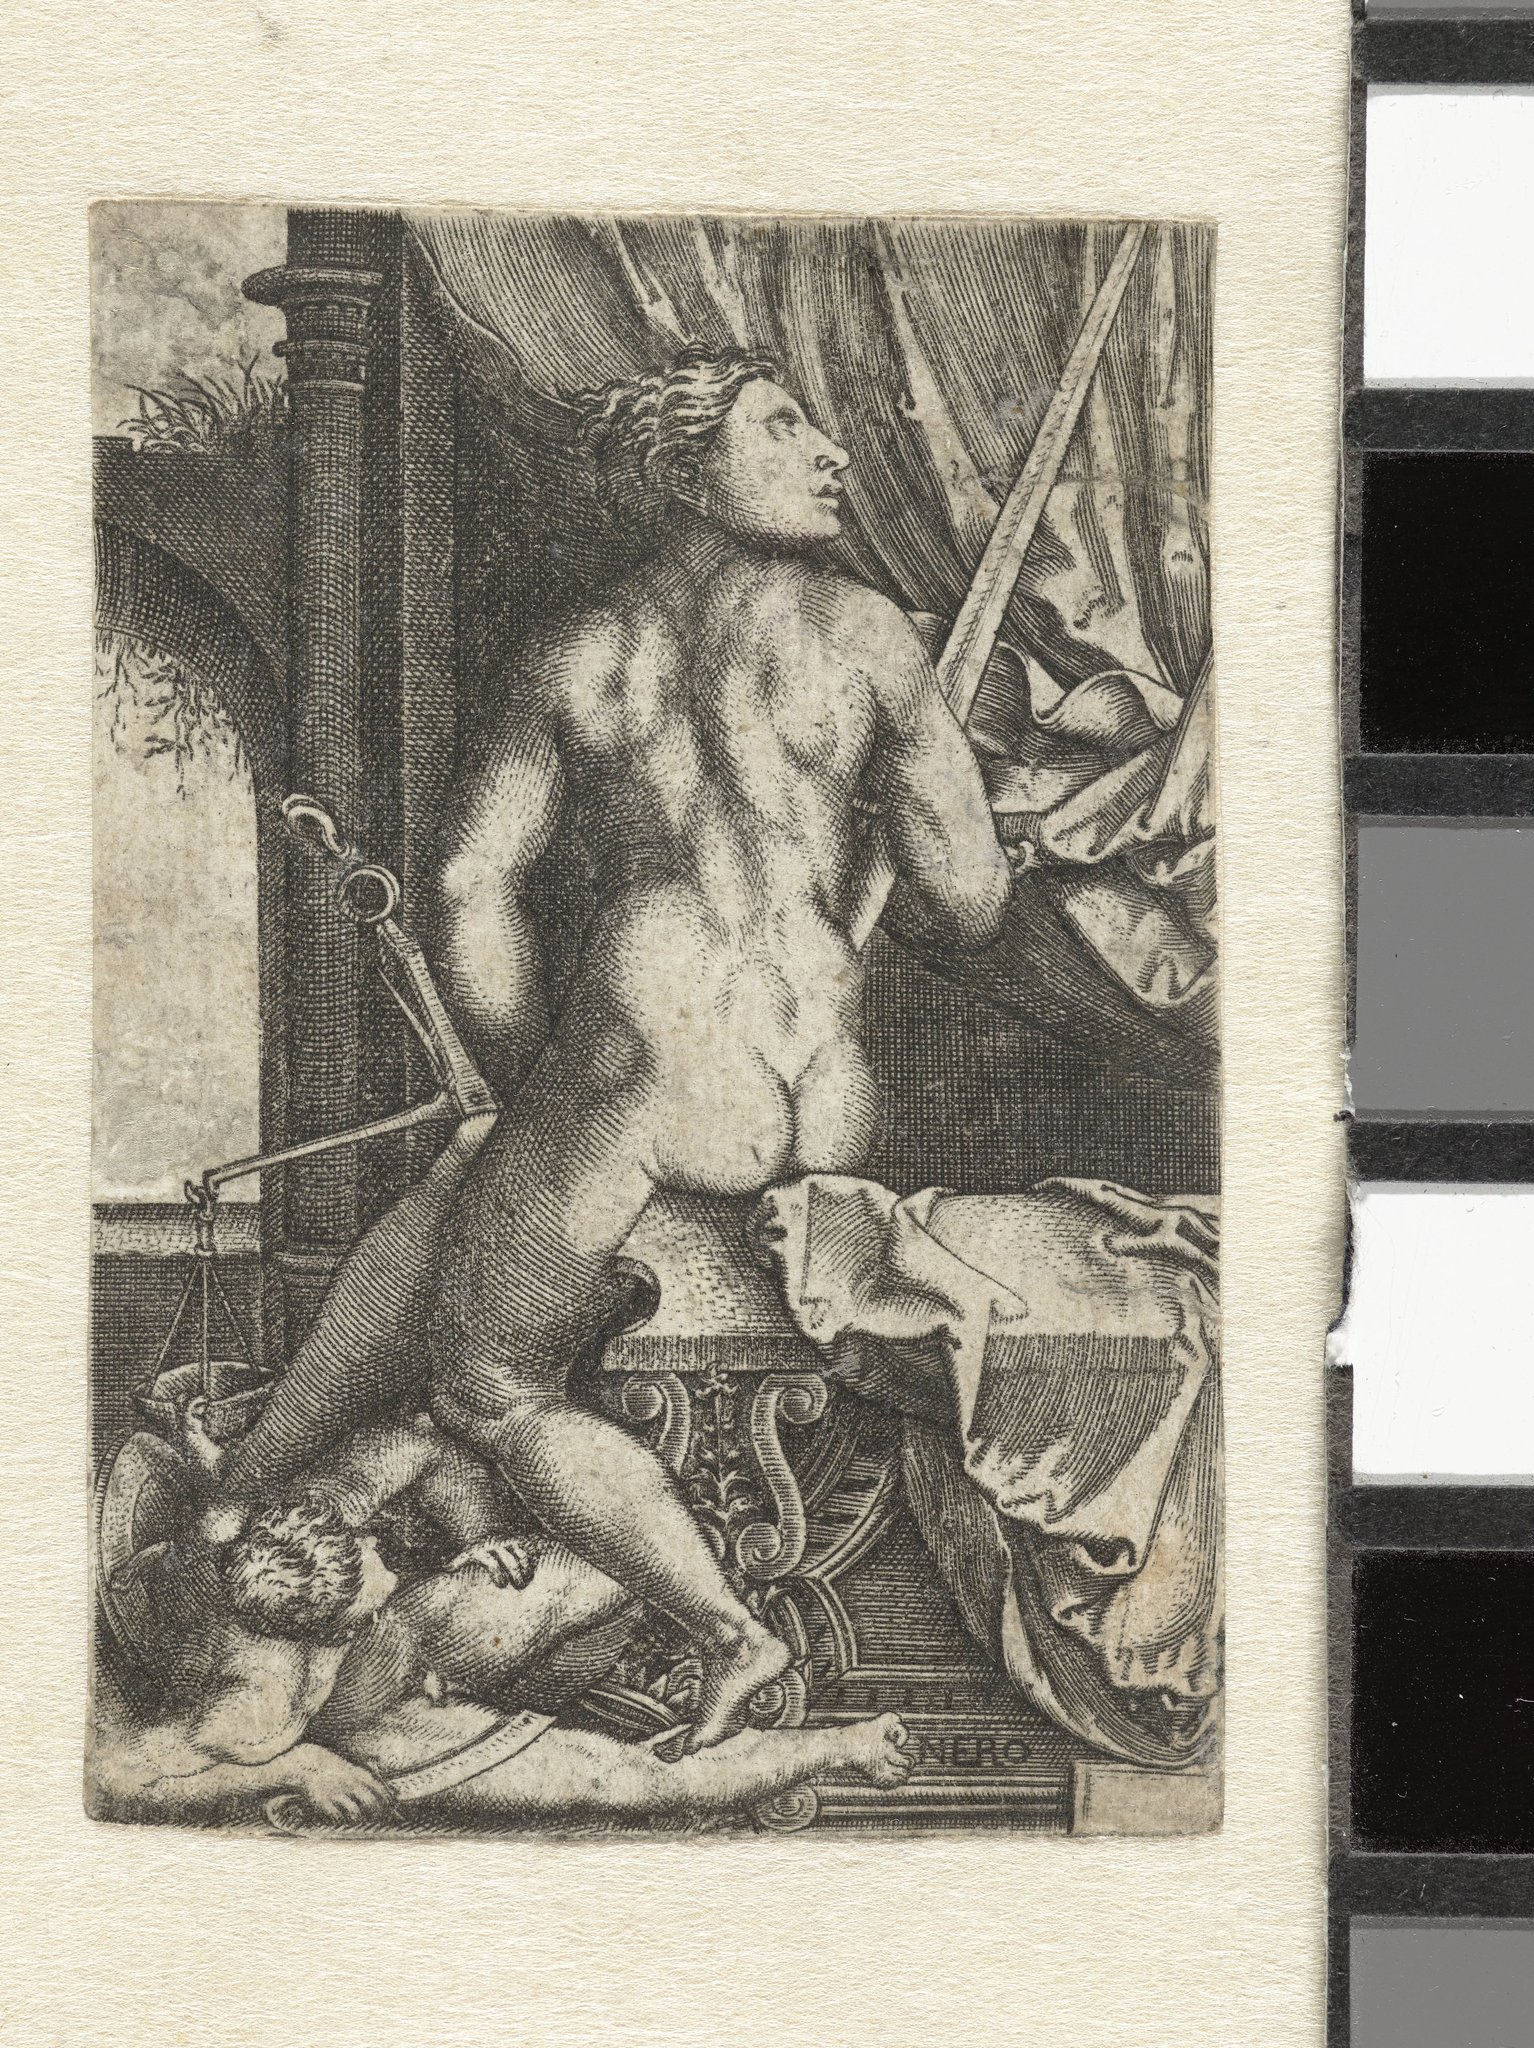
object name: print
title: Vrouwe Justitia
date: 1500-1600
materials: paper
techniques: etching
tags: justice; 'forza alla giustitia sottoposta', 'giustitia', 'giustitia retta', 'giustitia rigorosa', 'impietà e violenza soggetta alla giustitia' (ripa) (+ abstract concept represented by female figure)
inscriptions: collector's mark: Lugt 2228, collector's mark: Lugt 1134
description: Justitia naakt, in haar rechterhand een zwaard, links van haar een weegschaal en onder haar voeten lijkt zij een kind te vertrappen.